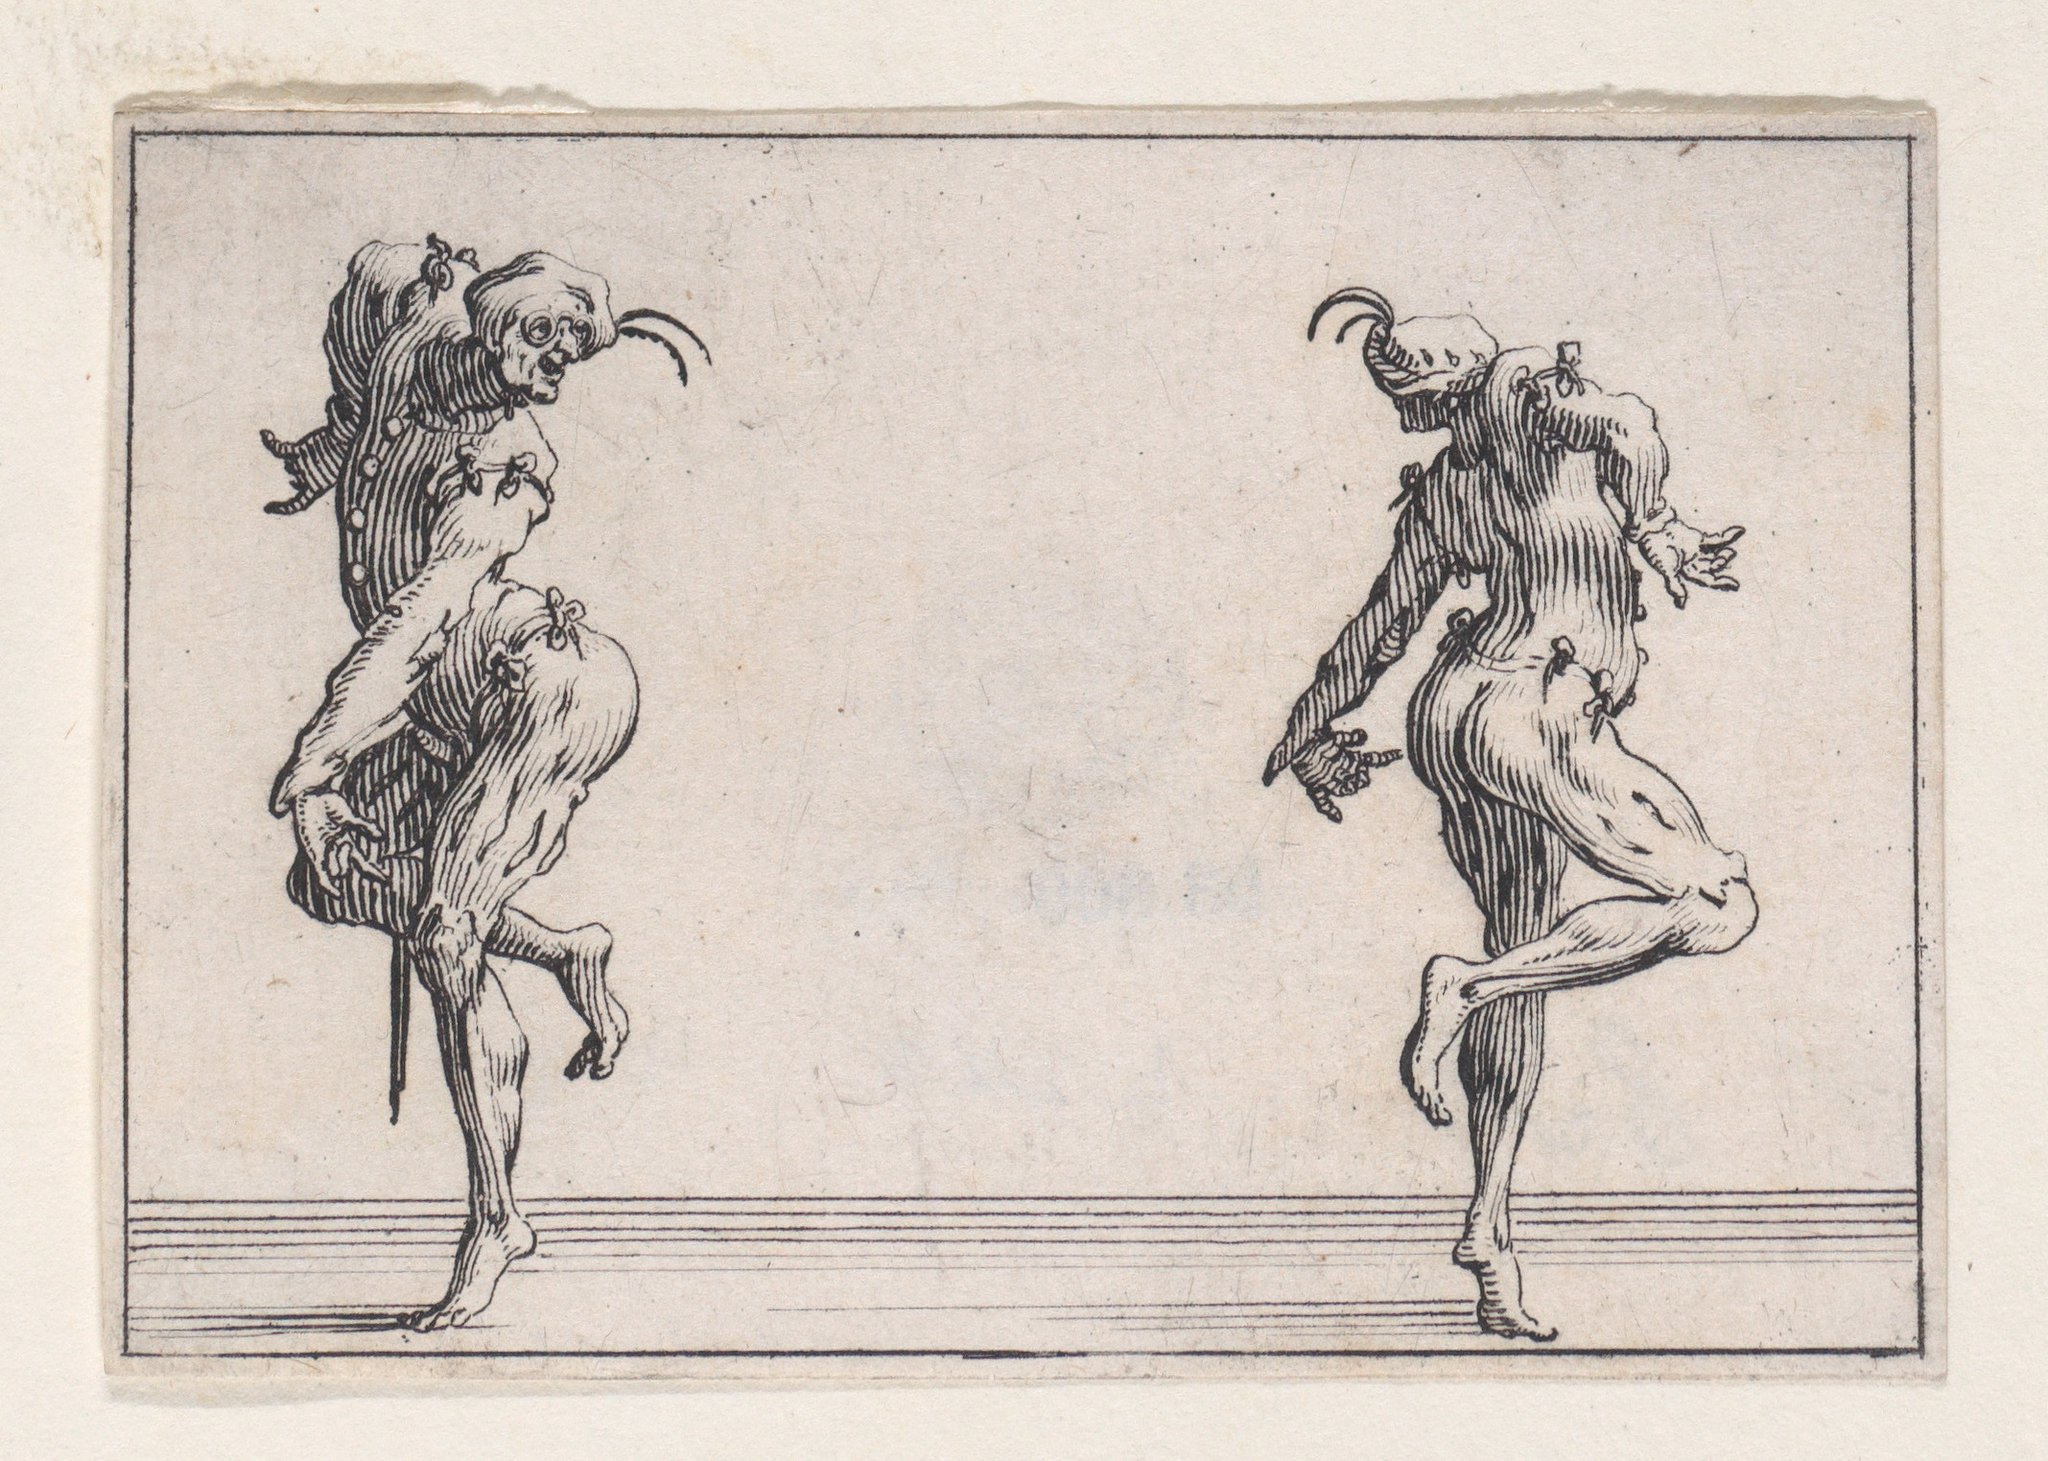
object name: print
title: Les Deux Pantalons se Tournant le Dos (Two Men in Pantsuits Turned Away from Each Other), from Les Caprices Series A, The Florence Set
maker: jacques callot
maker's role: artist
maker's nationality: french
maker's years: 1592-1635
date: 1617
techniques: etching